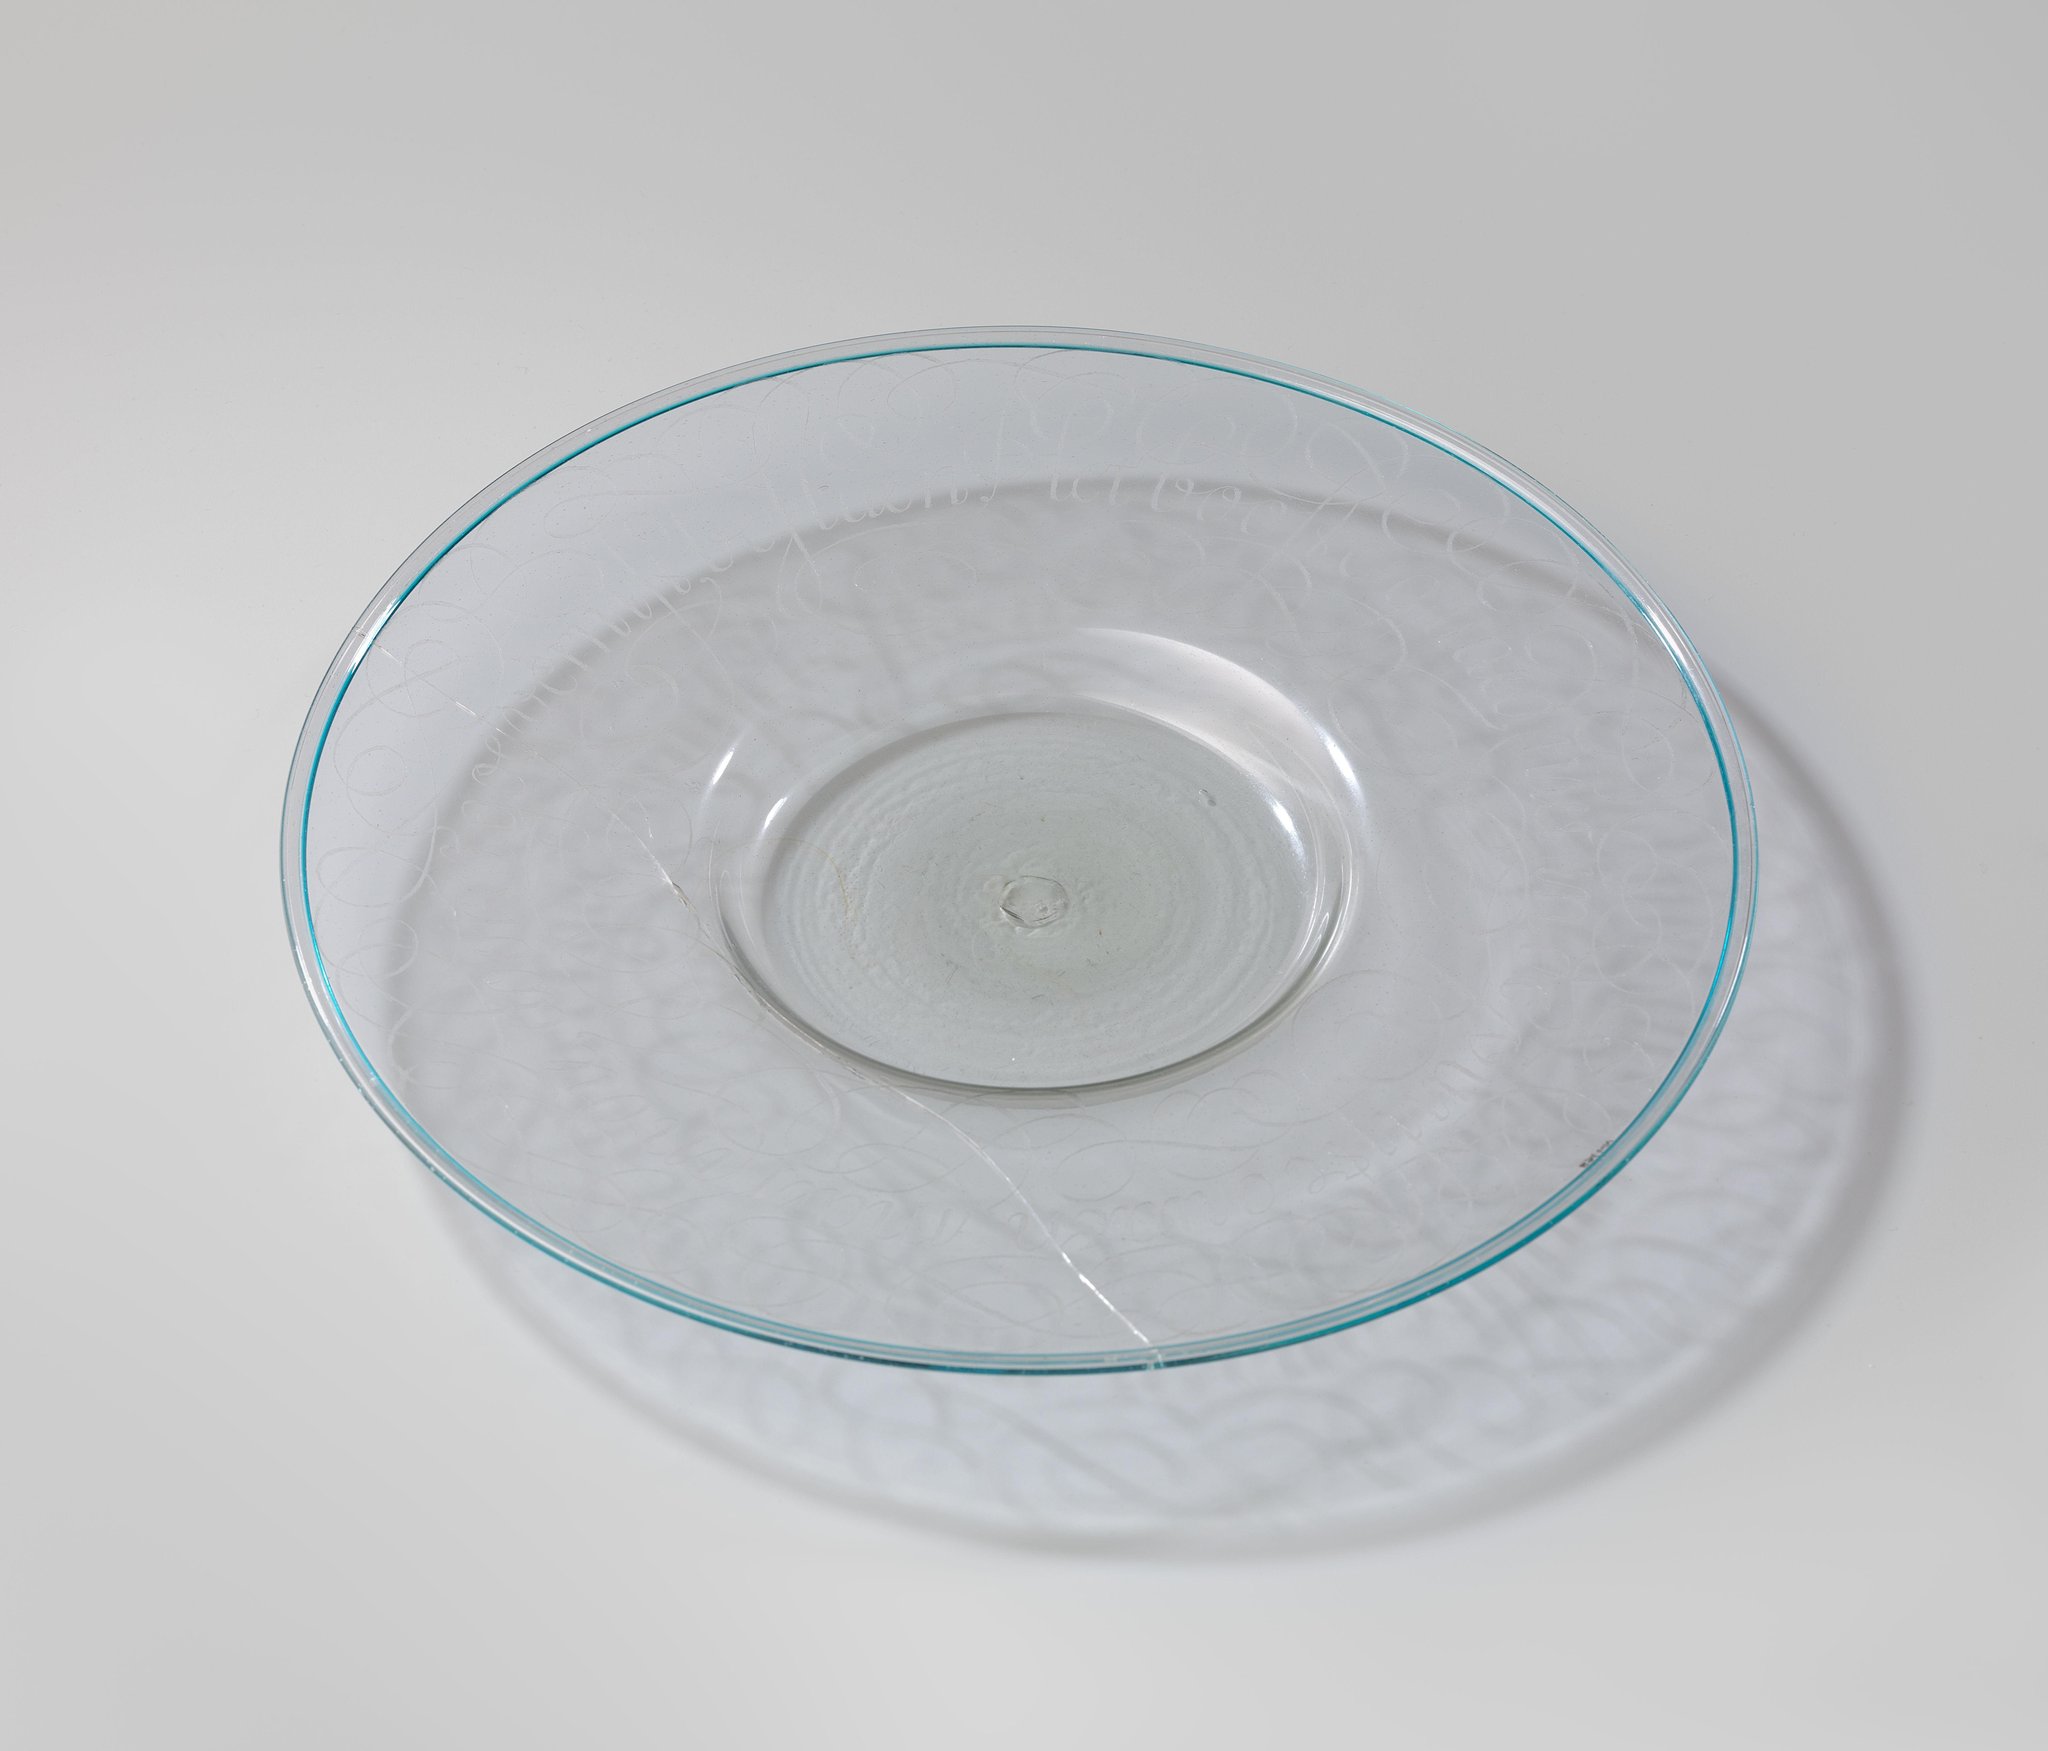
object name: platter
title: Schotel met het opschrift: Het booste quaed, niet in de vuilste quaen, maer in die, door 'et goe vernist, bestaen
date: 1675-1692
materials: glass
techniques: diamond point engraving, façon de venise, glassblowing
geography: low countries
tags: leiden, willem jacobszoon van heemskerk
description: Ronde schotel met omgeslagen rand, waarin een blauwe draad is gesmolten. Op de brede rand is in Italiaanse letters de volgende tekst gegraveerd 'Het booste quaed, niet in de vuilste quaen, maer in die, door 'et goe vernist, bestaen.'.